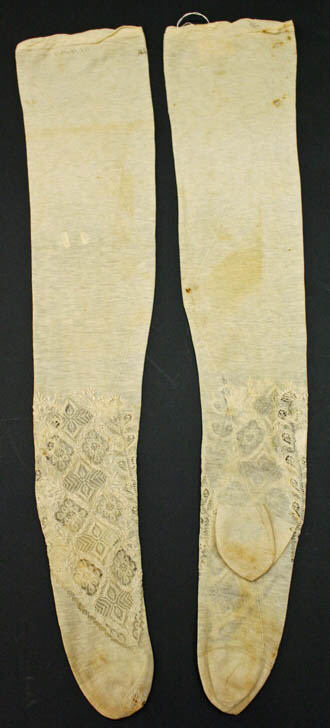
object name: stocking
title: Stockings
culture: french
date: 1801-1900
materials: cotton